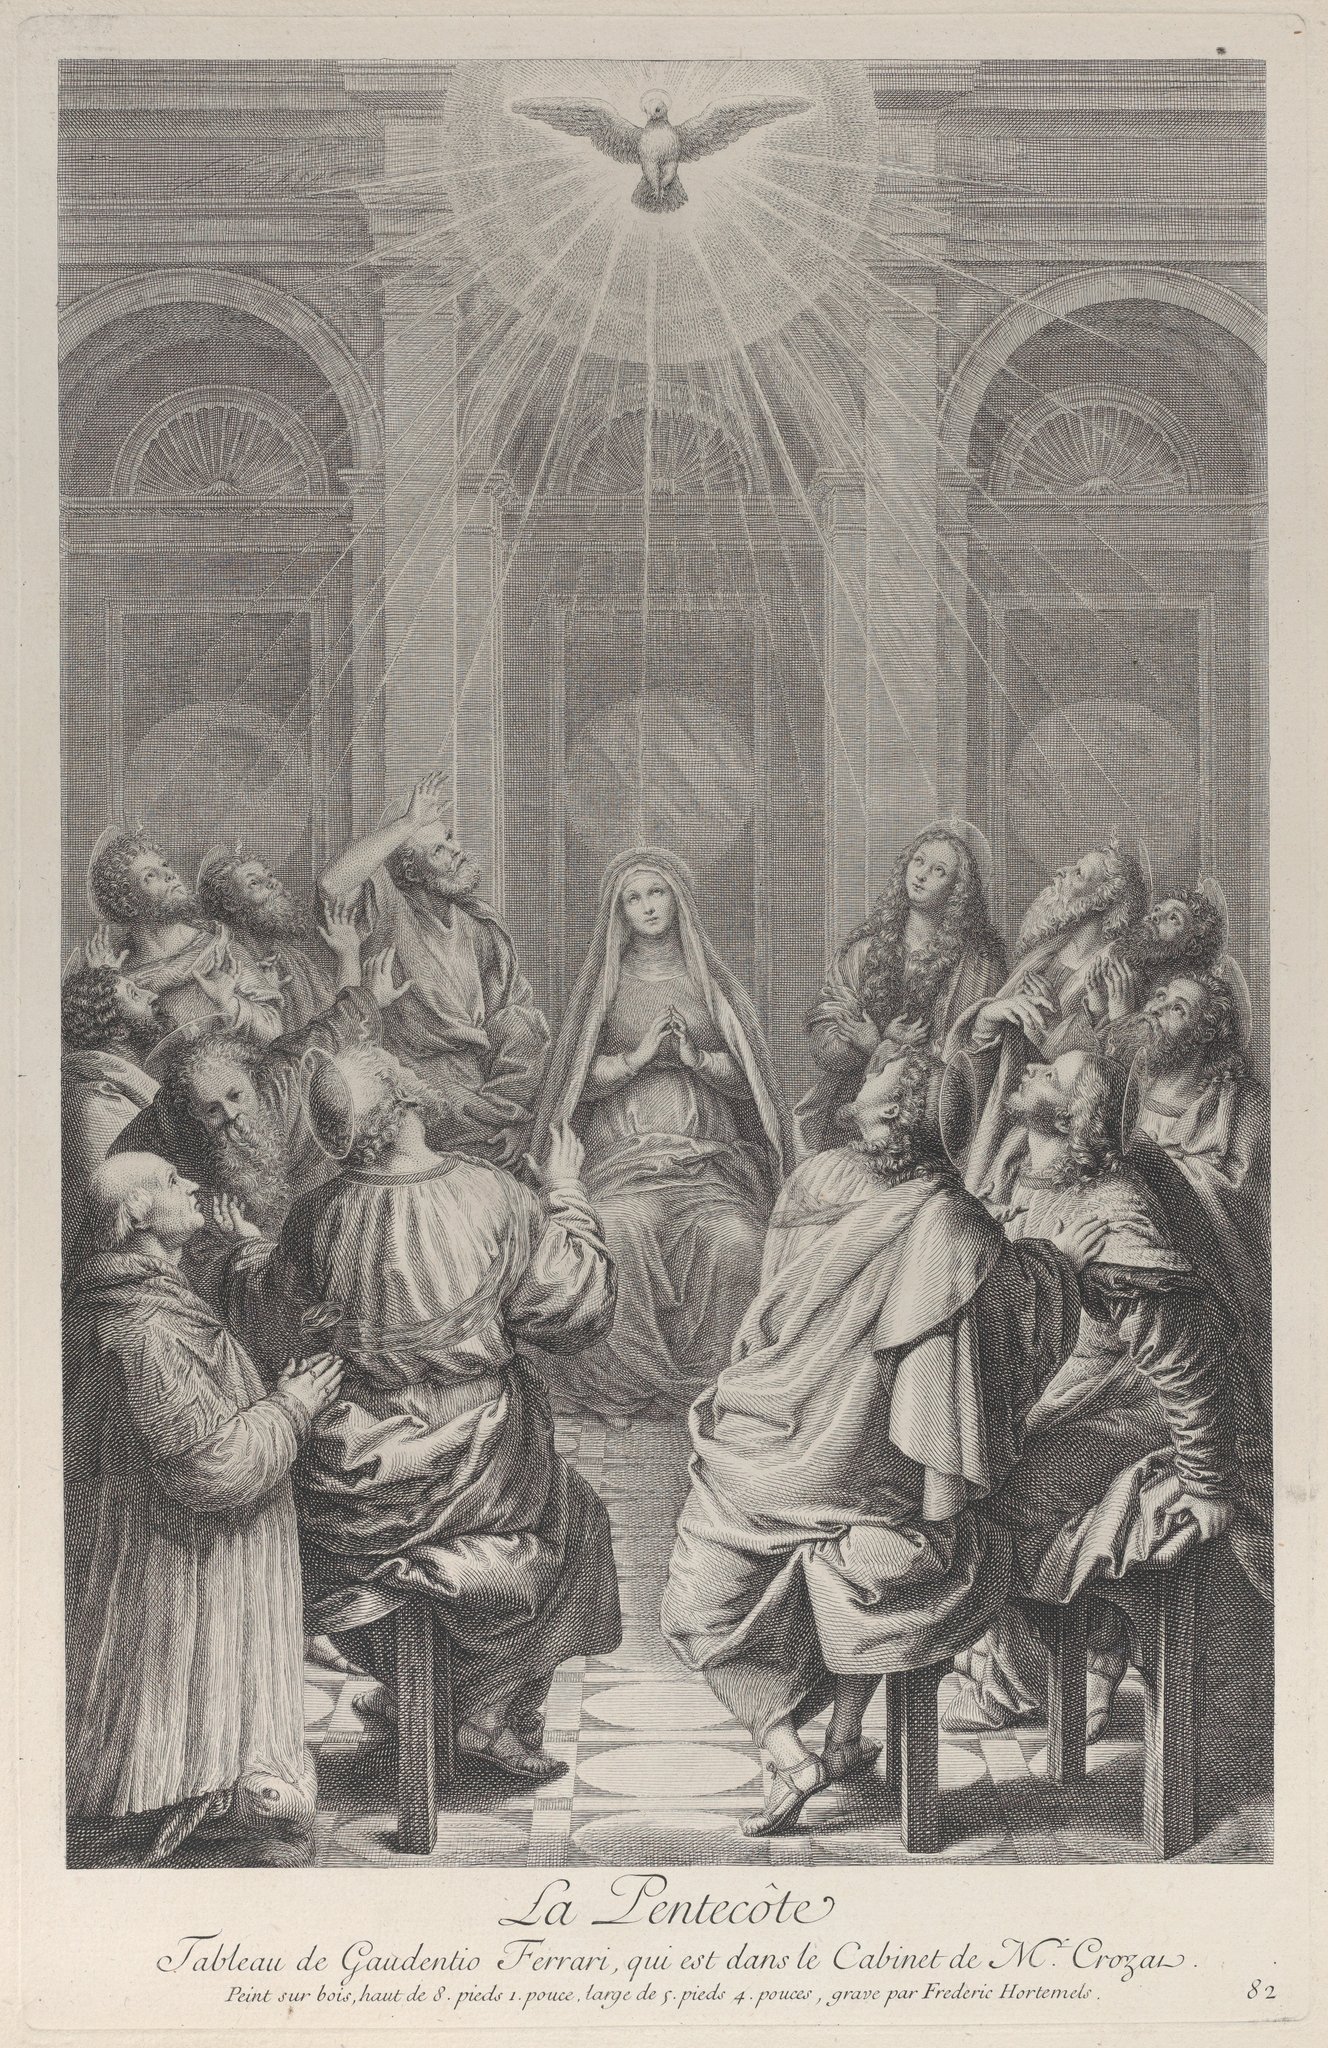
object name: print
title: The Pentecost, with the Apostles and the Virgin sitting in a circle, the Holy Spirit appearing above them, and a donor kneeling at left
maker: frédéric horthemels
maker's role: artist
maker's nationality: french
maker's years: 1680-1738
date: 1729-1740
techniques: engraving, etching